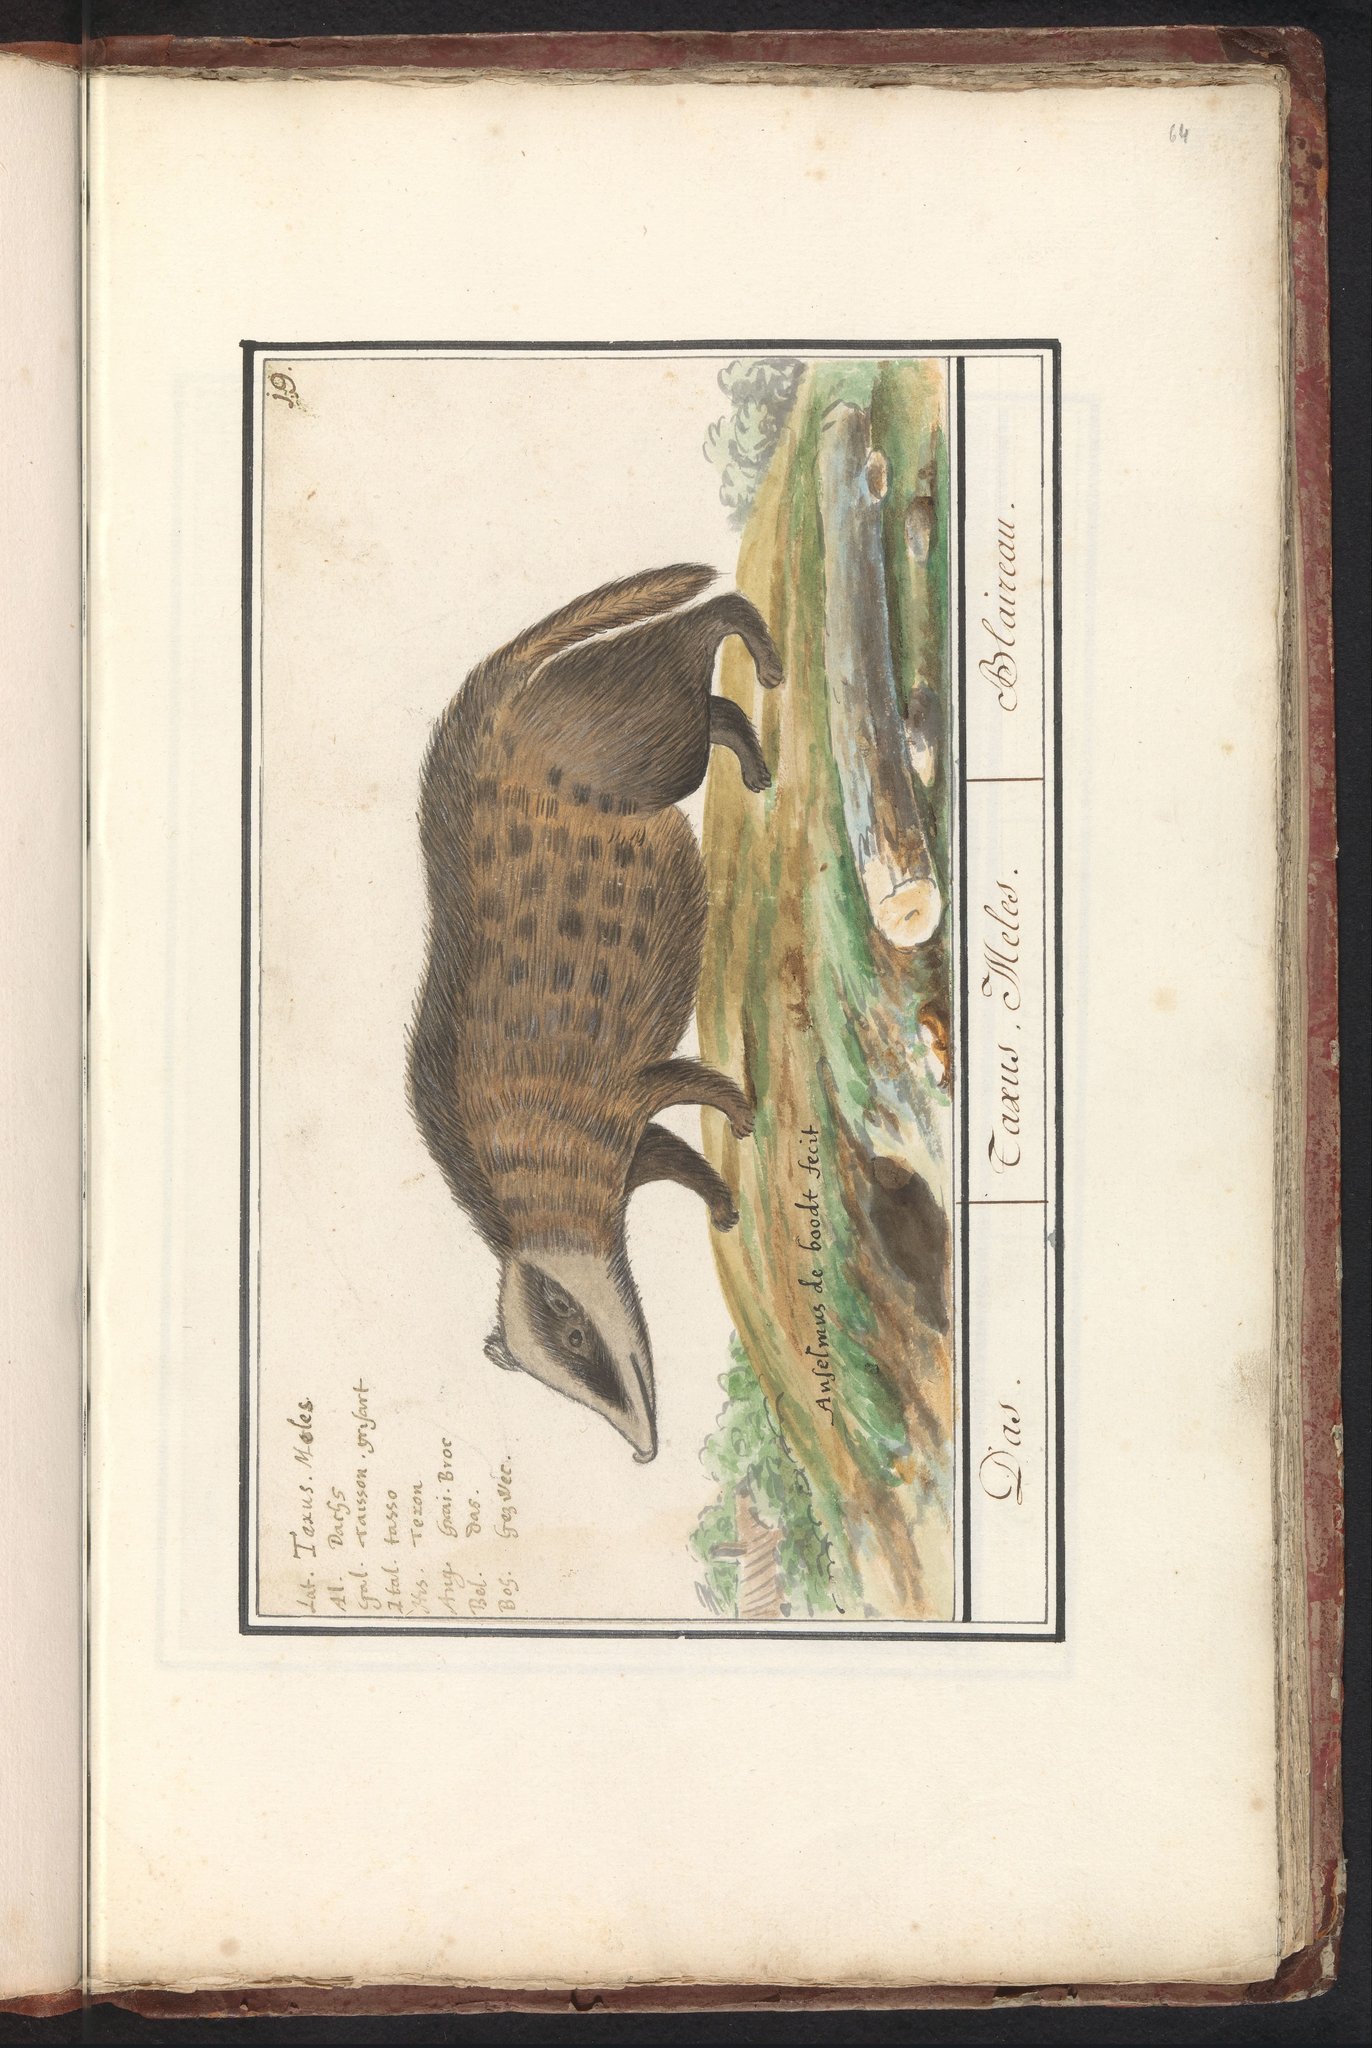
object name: drawing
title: Das. / Taxus Melus. / Blaireau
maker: anselmus boëtius de boodt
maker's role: draughtsman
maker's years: 1550-1632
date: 1596-1610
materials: paint, ink, paper, watercolor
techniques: brush, pen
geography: prague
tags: beasts of prey, predatory animals: badger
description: Das. Rechtsboven genummerd: 19. Linksboven de naam in acht talen. Onderdeel van het eerste album met tekeningen van viervoeters. Eerste van twaalf albums met tekeningen van dieren, vogels en planten bekend rond 1600, gemaakt in opdracht van keizer Rudolf II. Met toelichting in Nederlands, Latijn en Frans.